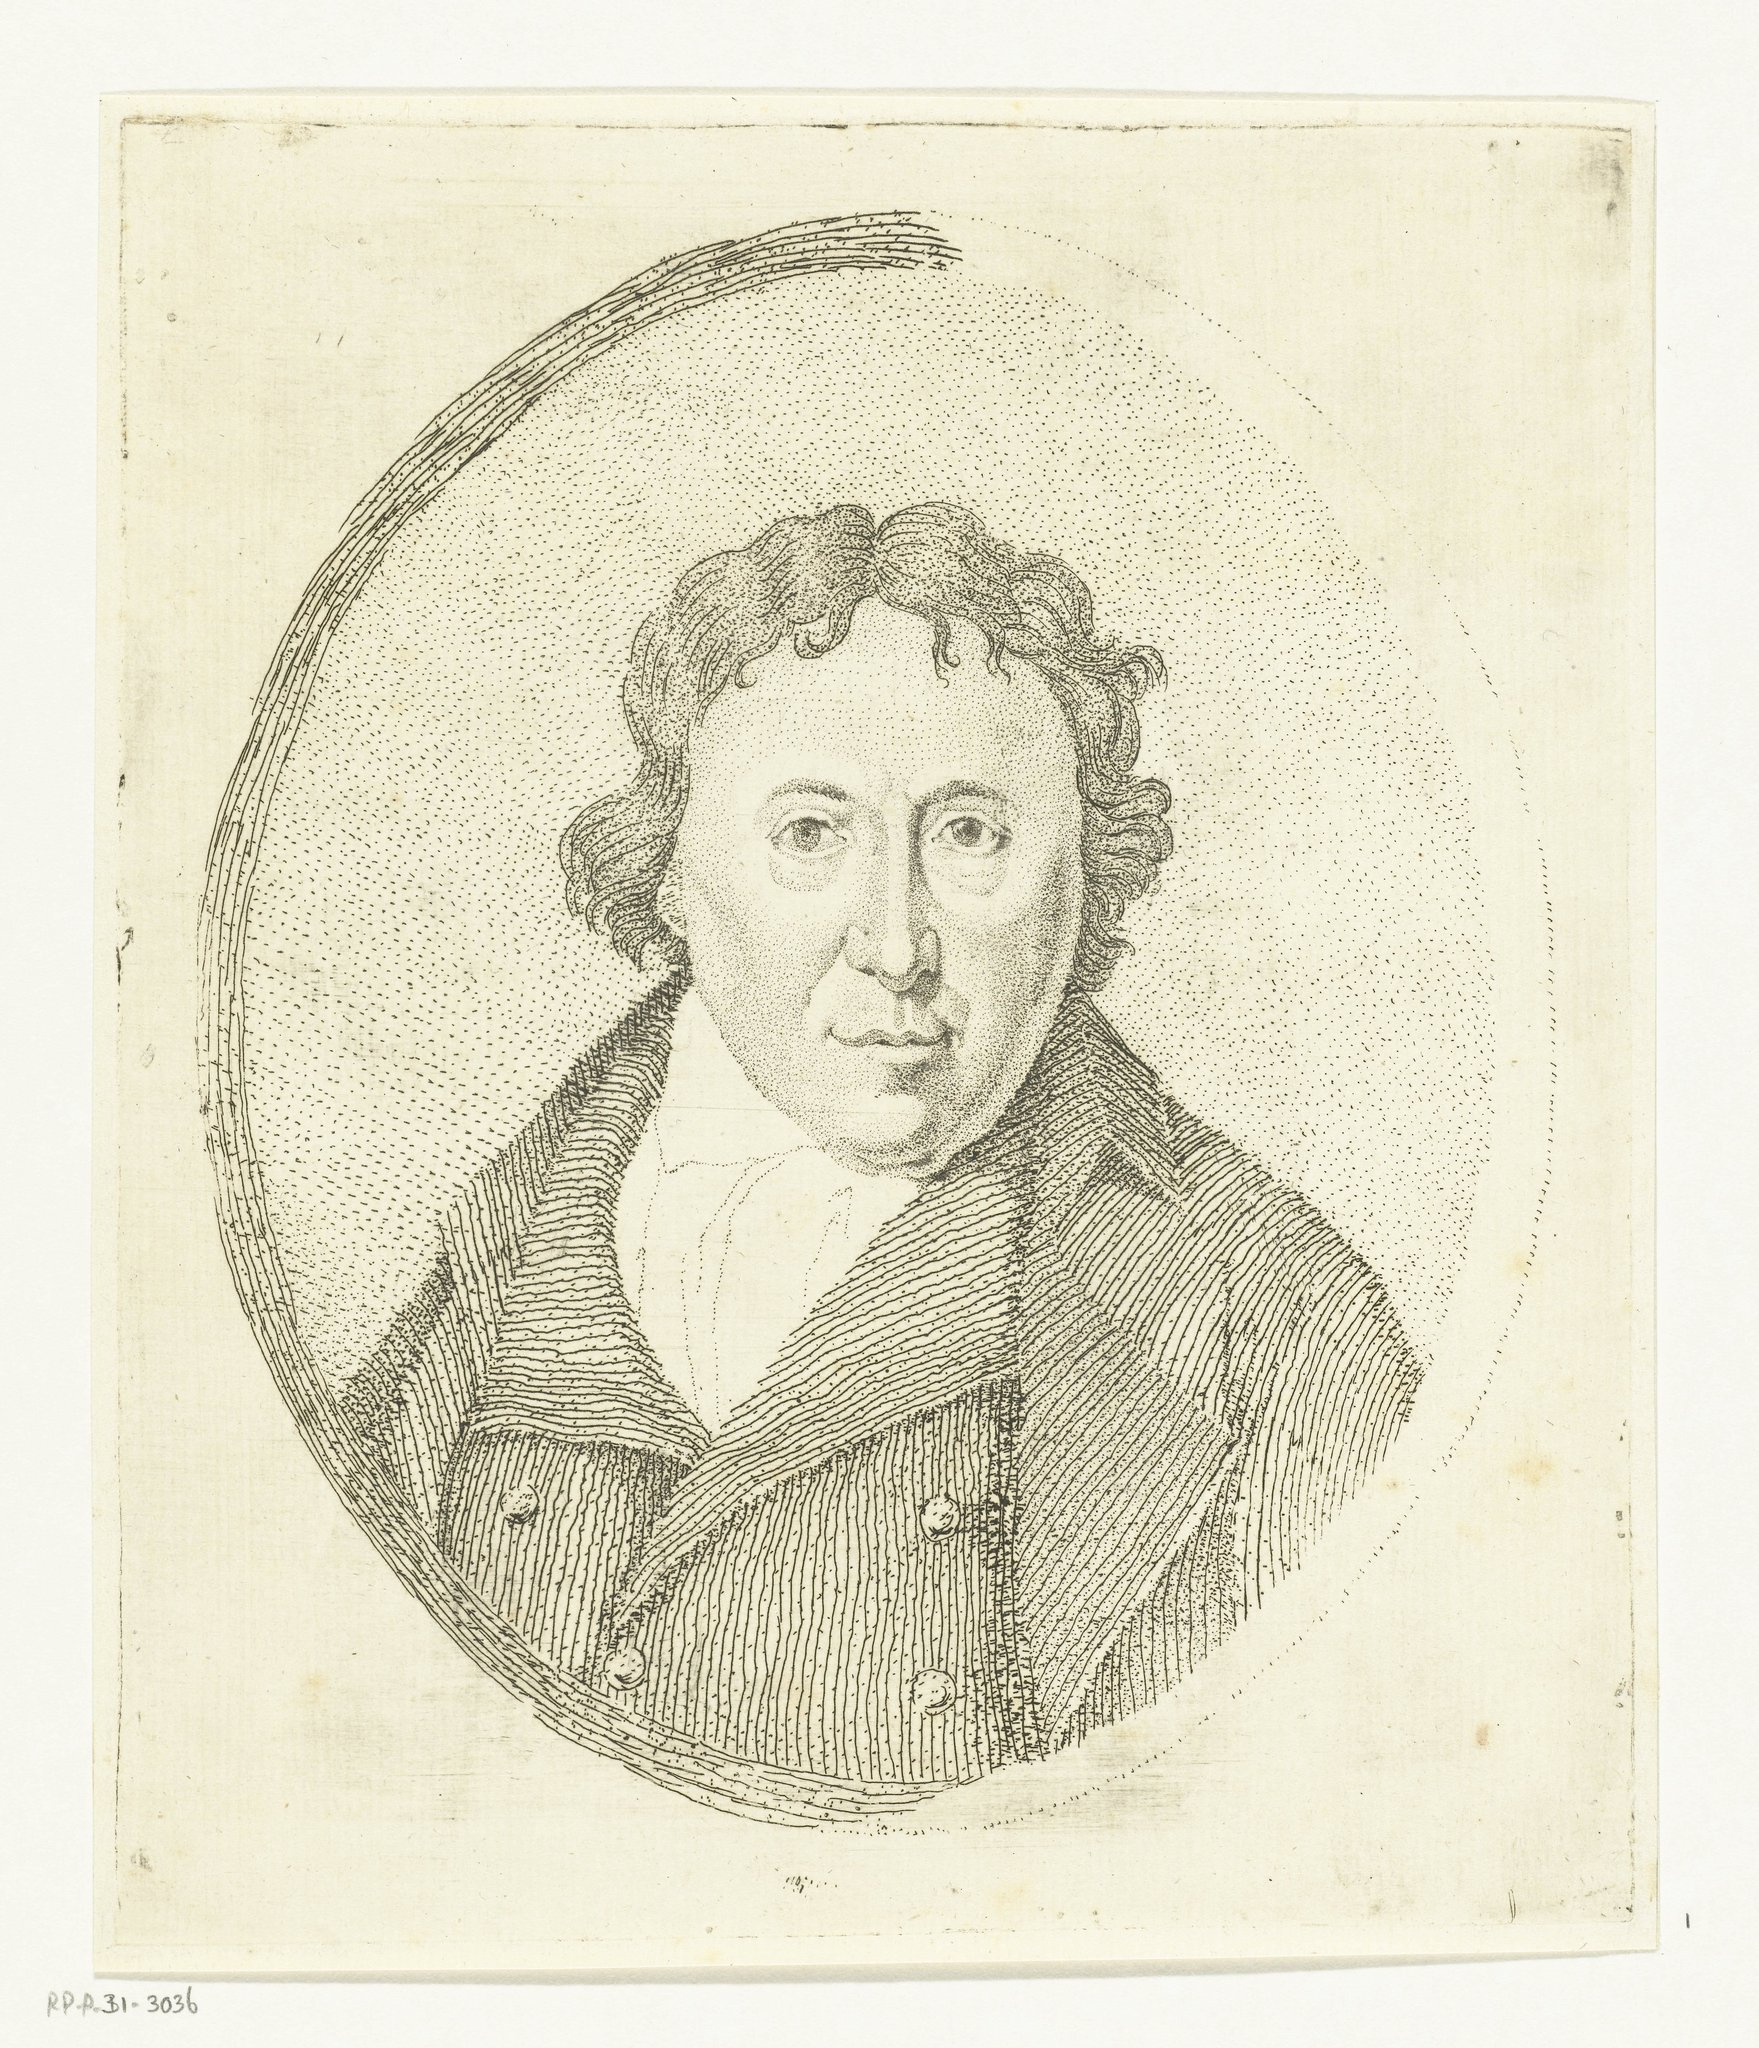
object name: print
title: Portret van Gerard van Nijmegen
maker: anthonie van den bos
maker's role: draughtsman, print maker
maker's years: 1763-1838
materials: paper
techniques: etching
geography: netherlands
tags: rotterdam, painter, print maker, draughtsman, gerard van nijmegen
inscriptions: collector's mark: Lugt 2228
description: Borstbeeld van de Rotterdamse schilder Gerard van Nijmegen.